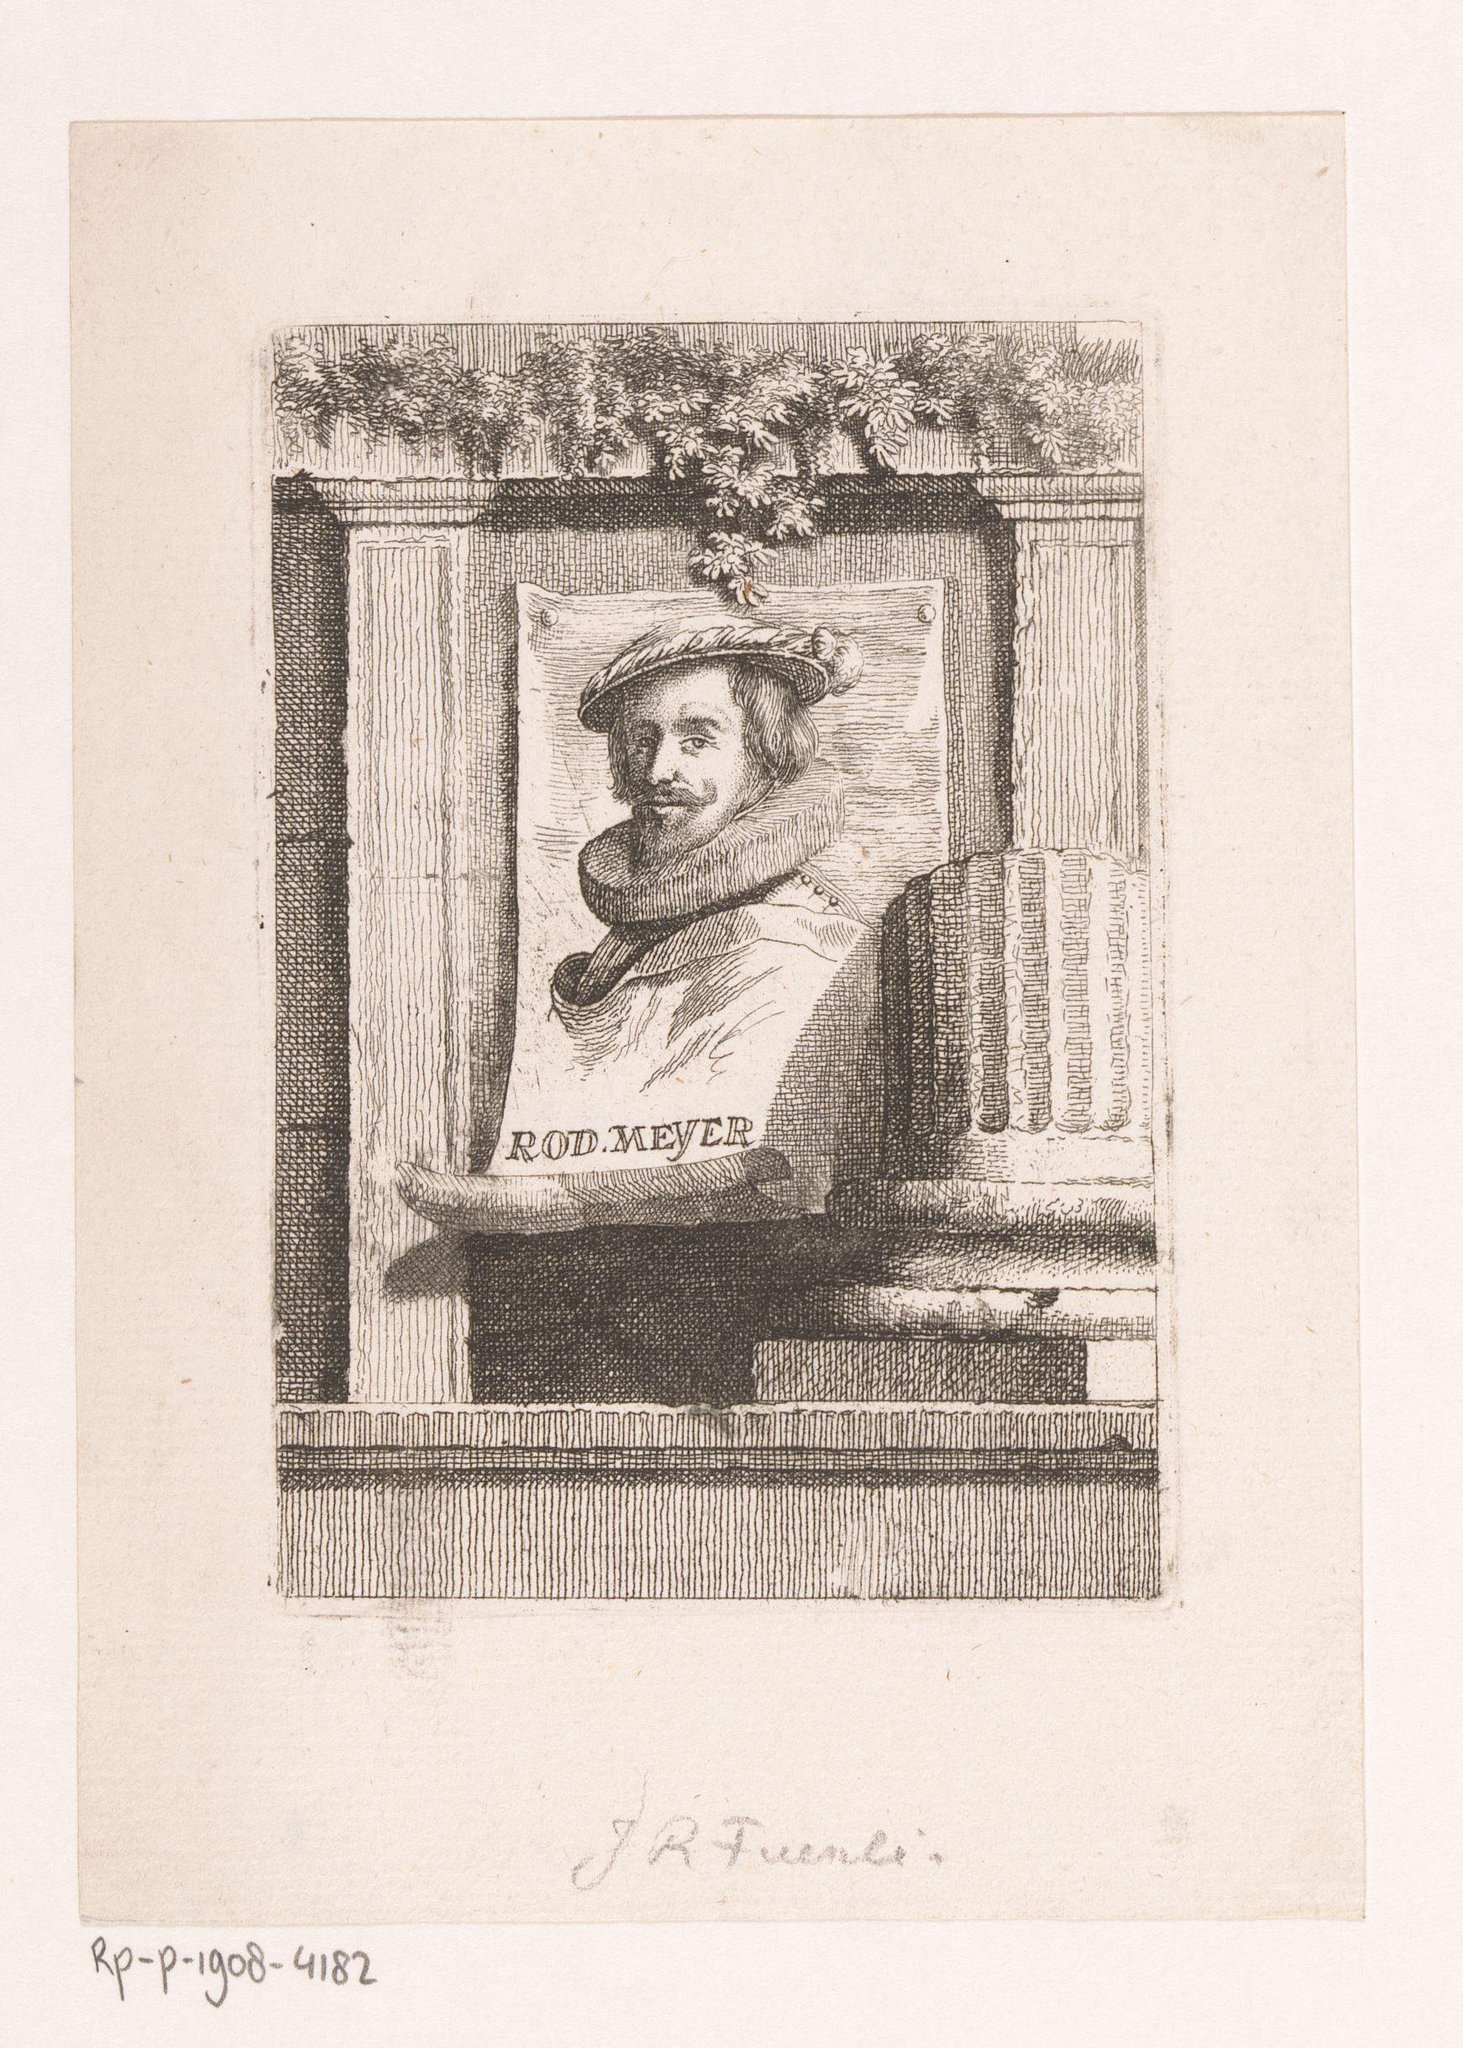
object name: print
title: Portret van Rudolf Meyer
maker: rudolf füssli (der jüngste)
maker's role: print maker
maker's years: 1737-1806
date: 1755-1757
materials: paper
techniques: etching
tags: painter, portrait, self-portrait of painter, ornament derived from architectural details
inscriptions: collector's mark: Lugt 2228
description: Prent gebruikt voor: Füssli, Johann Kaspar. Geschichte Und Abbildung der besten Mahler in der Schweitz. Zürich: David Gessner, 1755-1757.